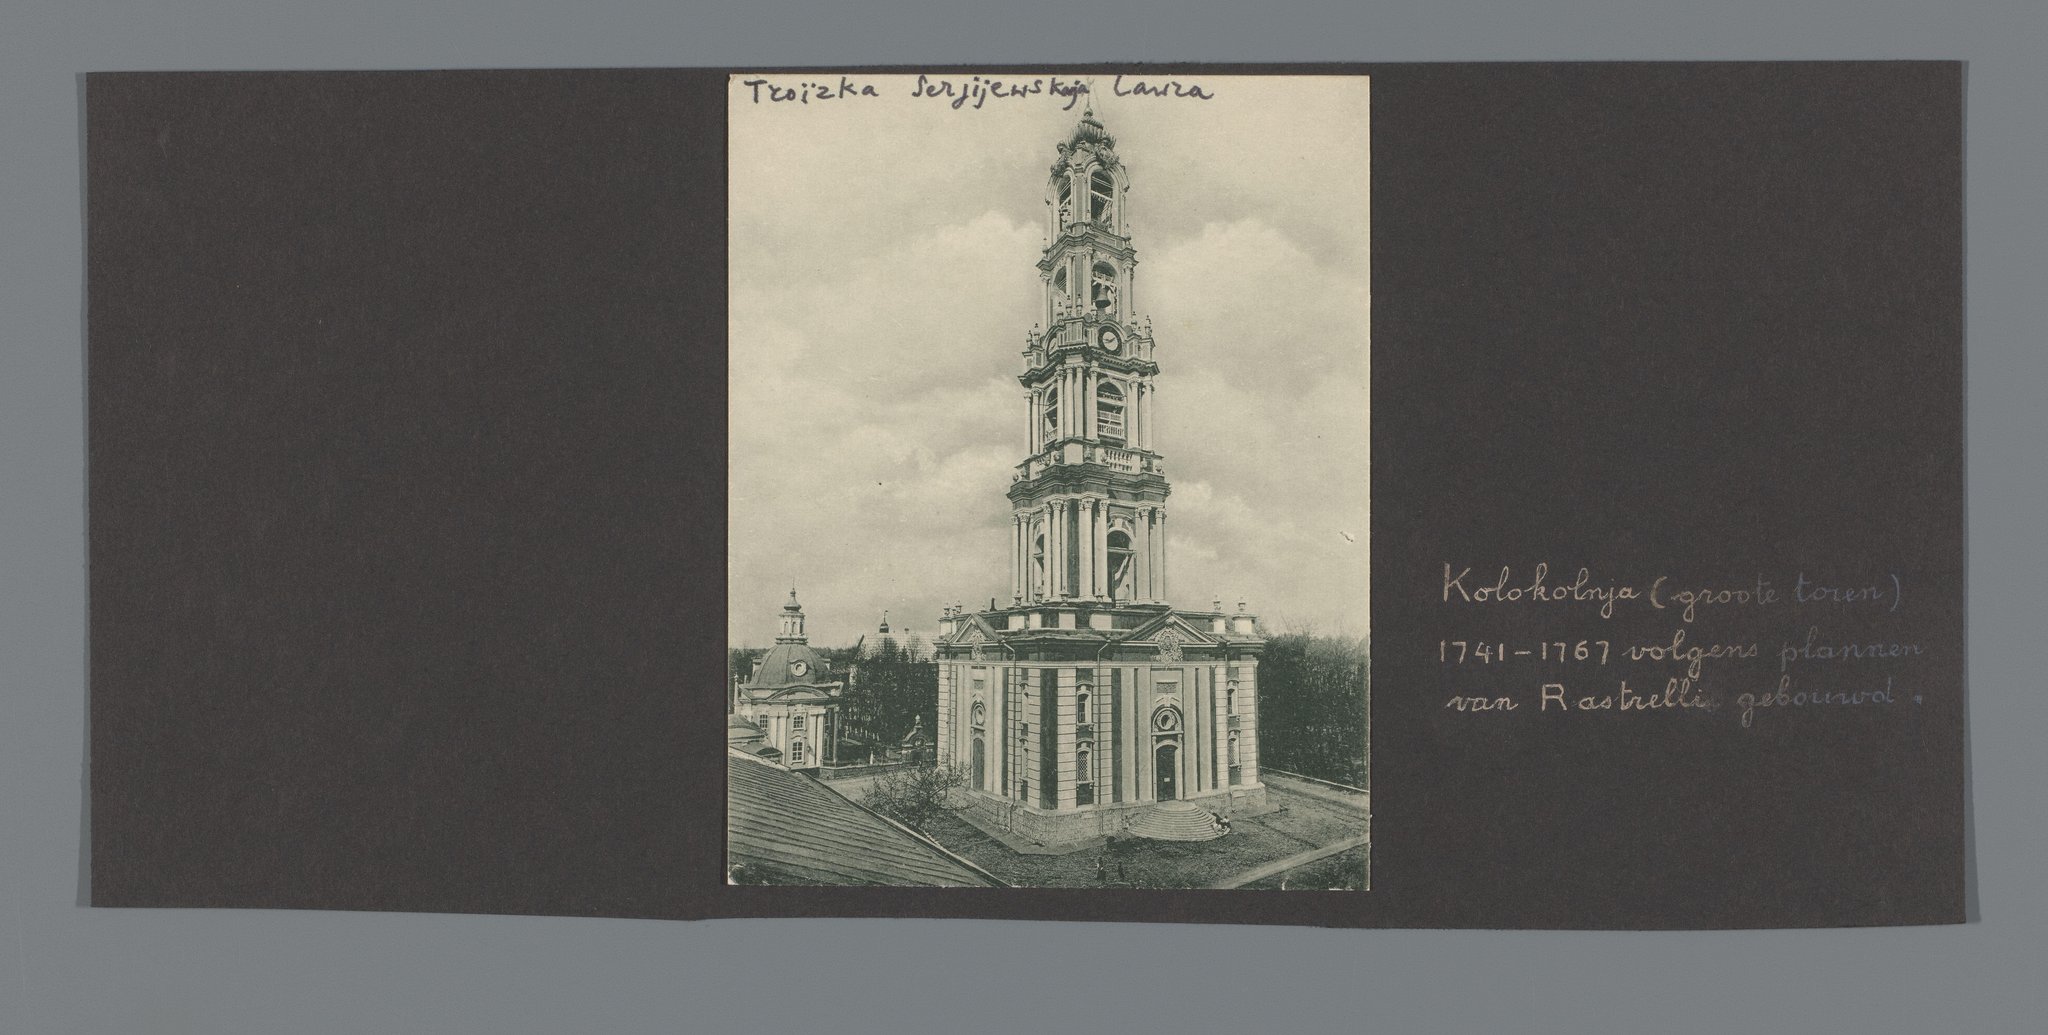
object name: photograph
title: Troïska Sergijewskaja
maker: Anonymous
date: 1860-1925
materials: photographic support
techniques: photograph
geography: russia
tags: russia